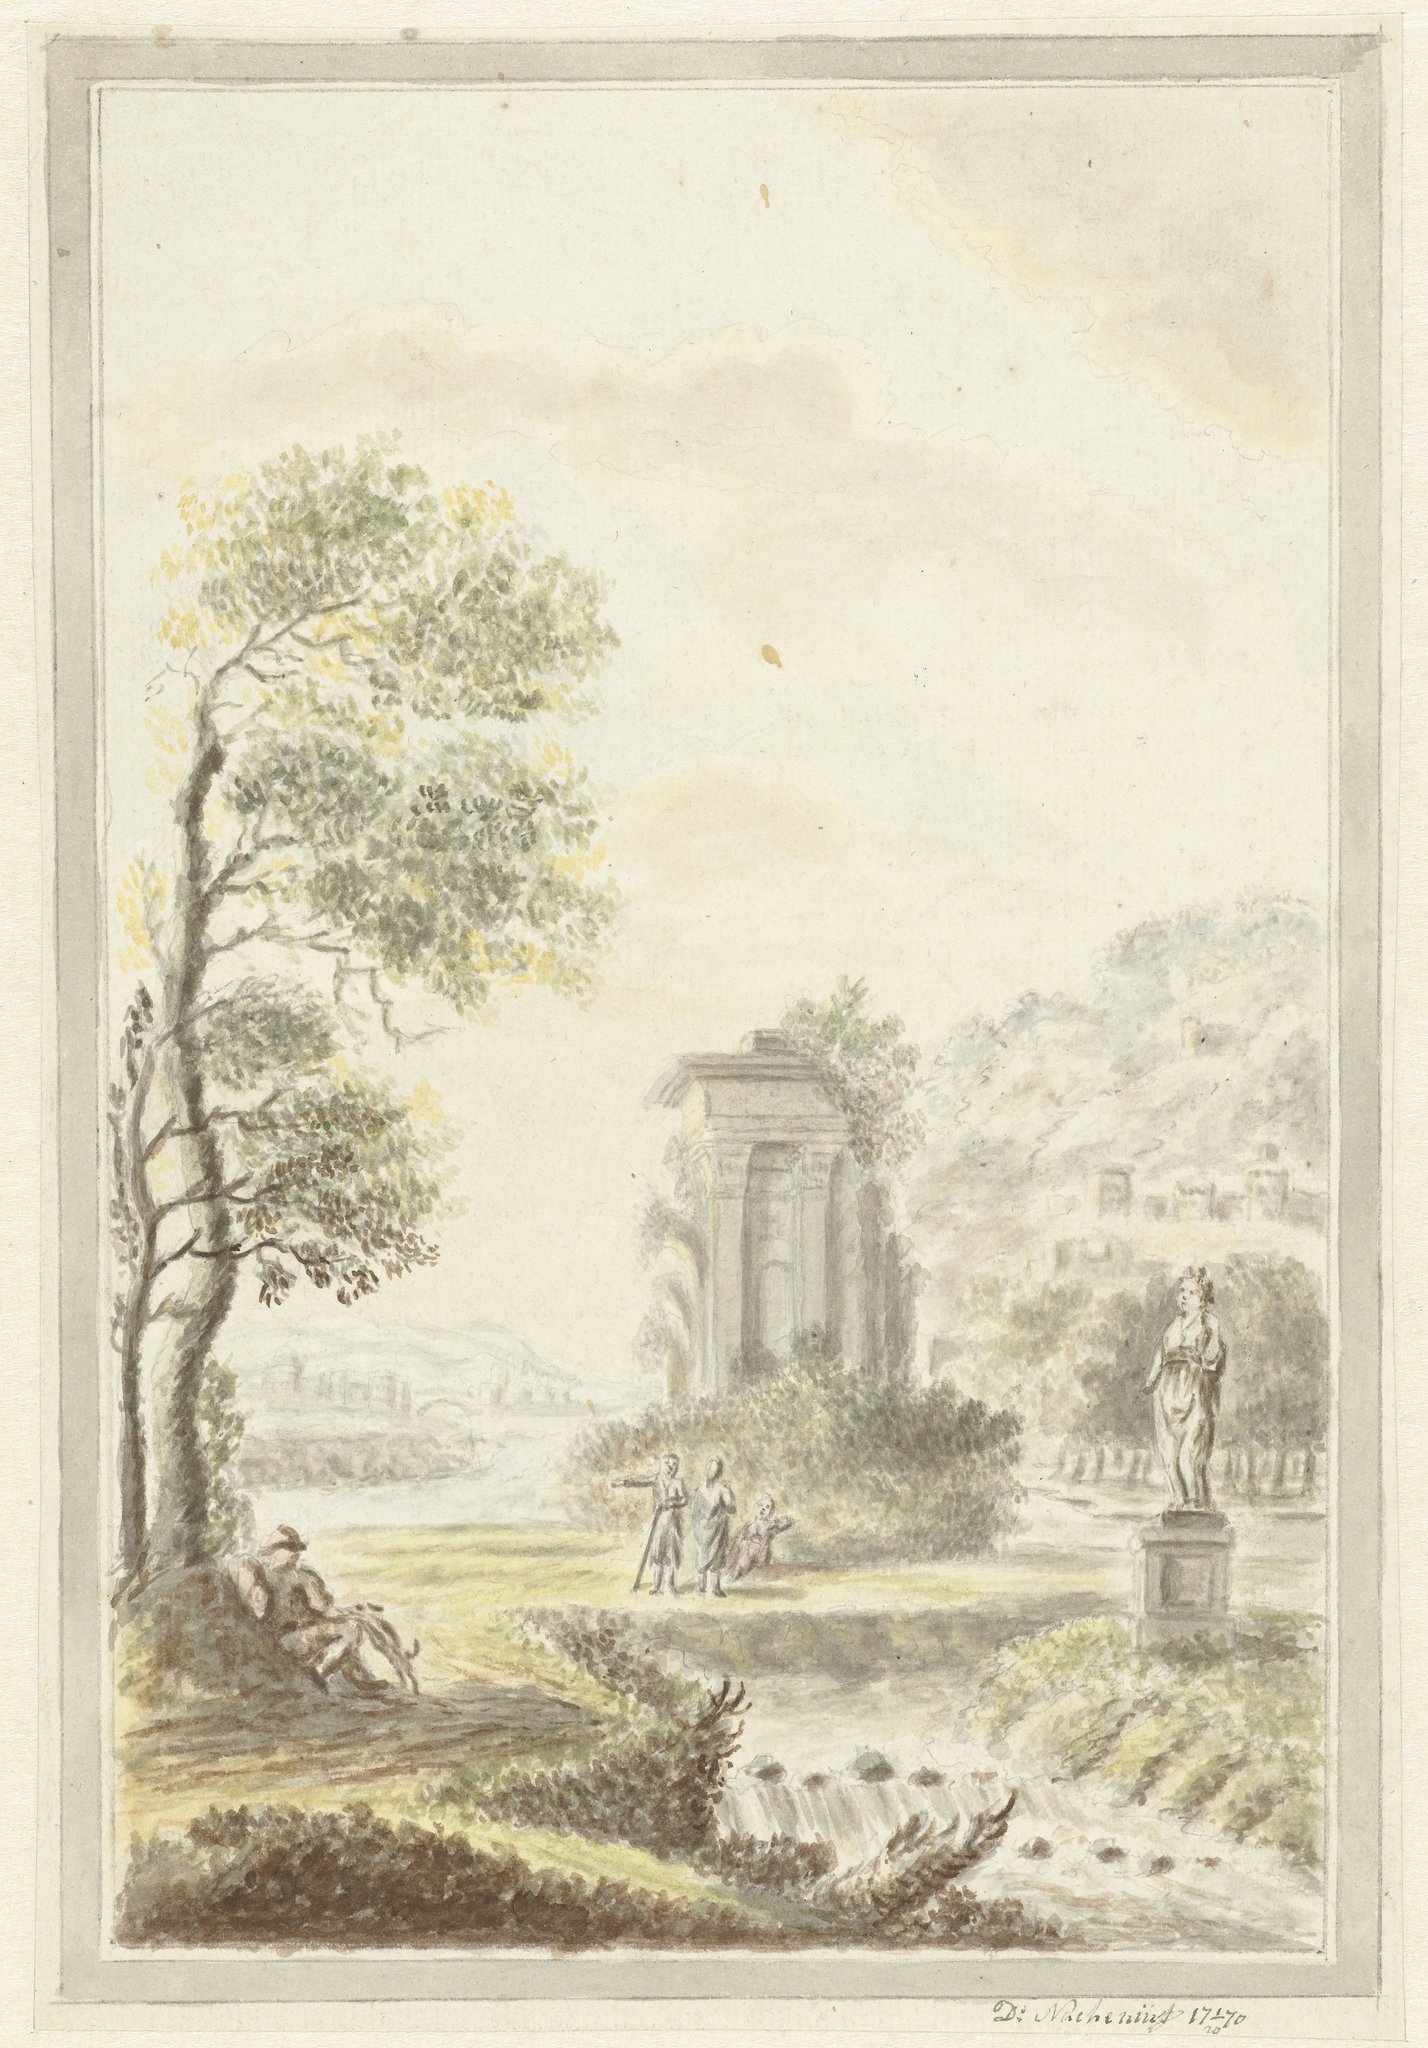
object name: watercolor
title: Arcadisch landschap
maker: d. nachenius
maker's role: draughtsman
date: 1770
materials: paper, pencil, watercolor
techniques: brush